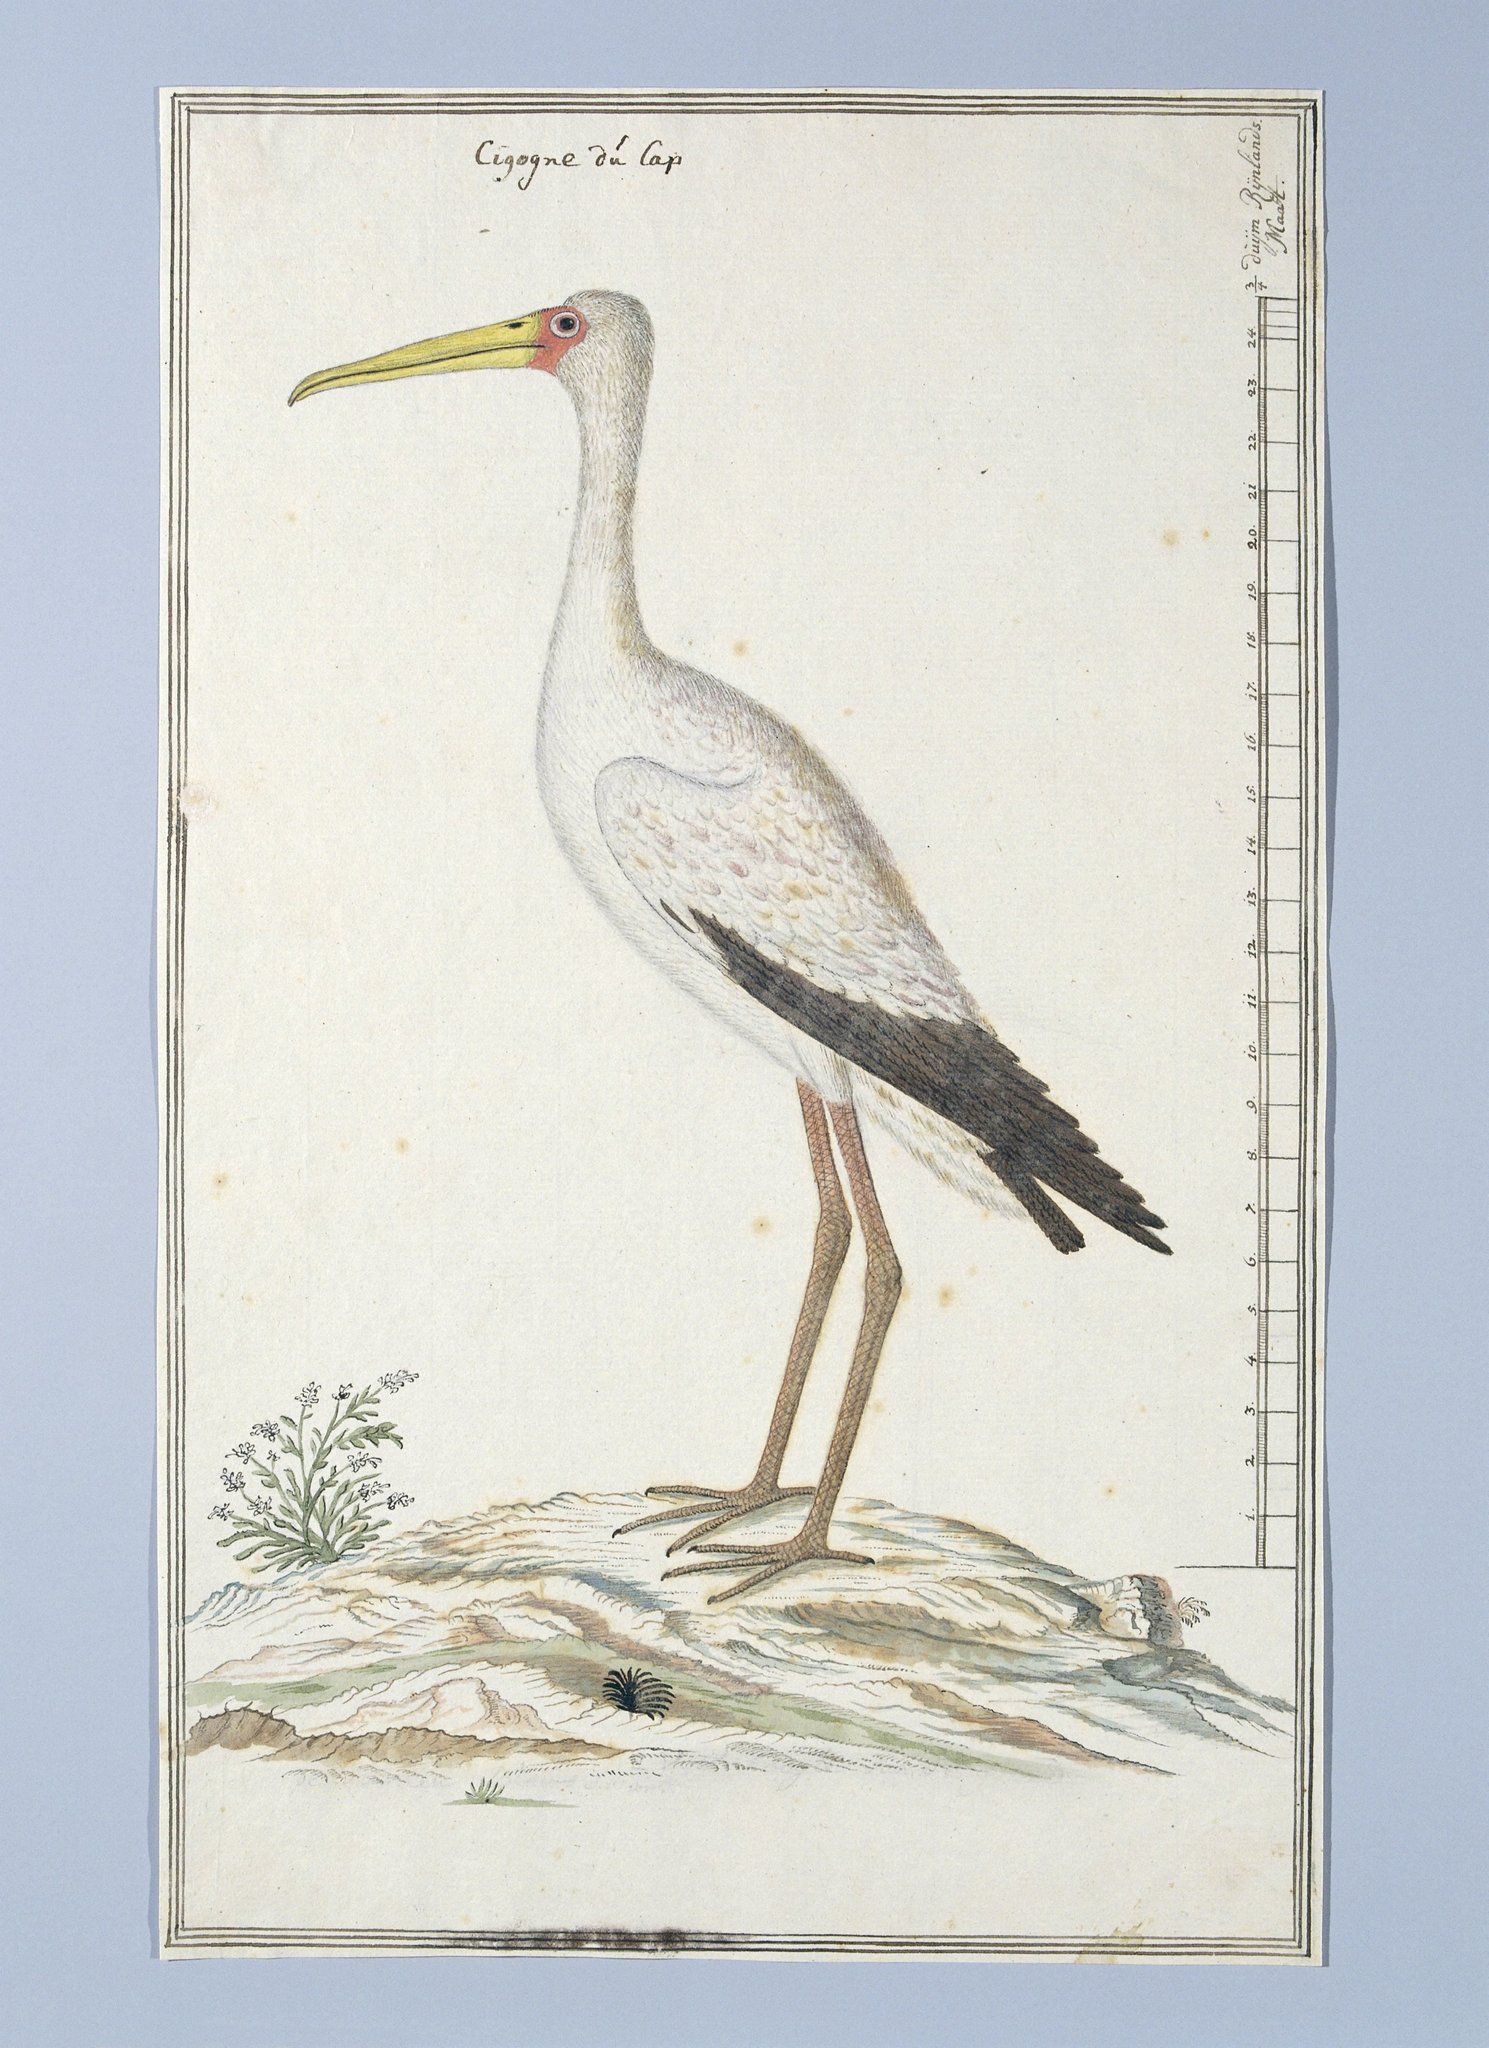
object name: album leaf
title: Mycteria ibis (Yellow-billed stork or Wood stork)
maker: robert jacob gordon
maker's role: draughtsman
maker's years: 1743-1795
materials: chalk, ink, paper, pencil, watercolor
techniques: brush, pen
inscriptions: annotation: ‘Cicogne dú Cap; schaal met: duijm Rijnlands. / Maat.’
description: Vogelstudie: Nimmerzat (Mycteria ibis); met schaalverdeling in Rijnlandse maat.